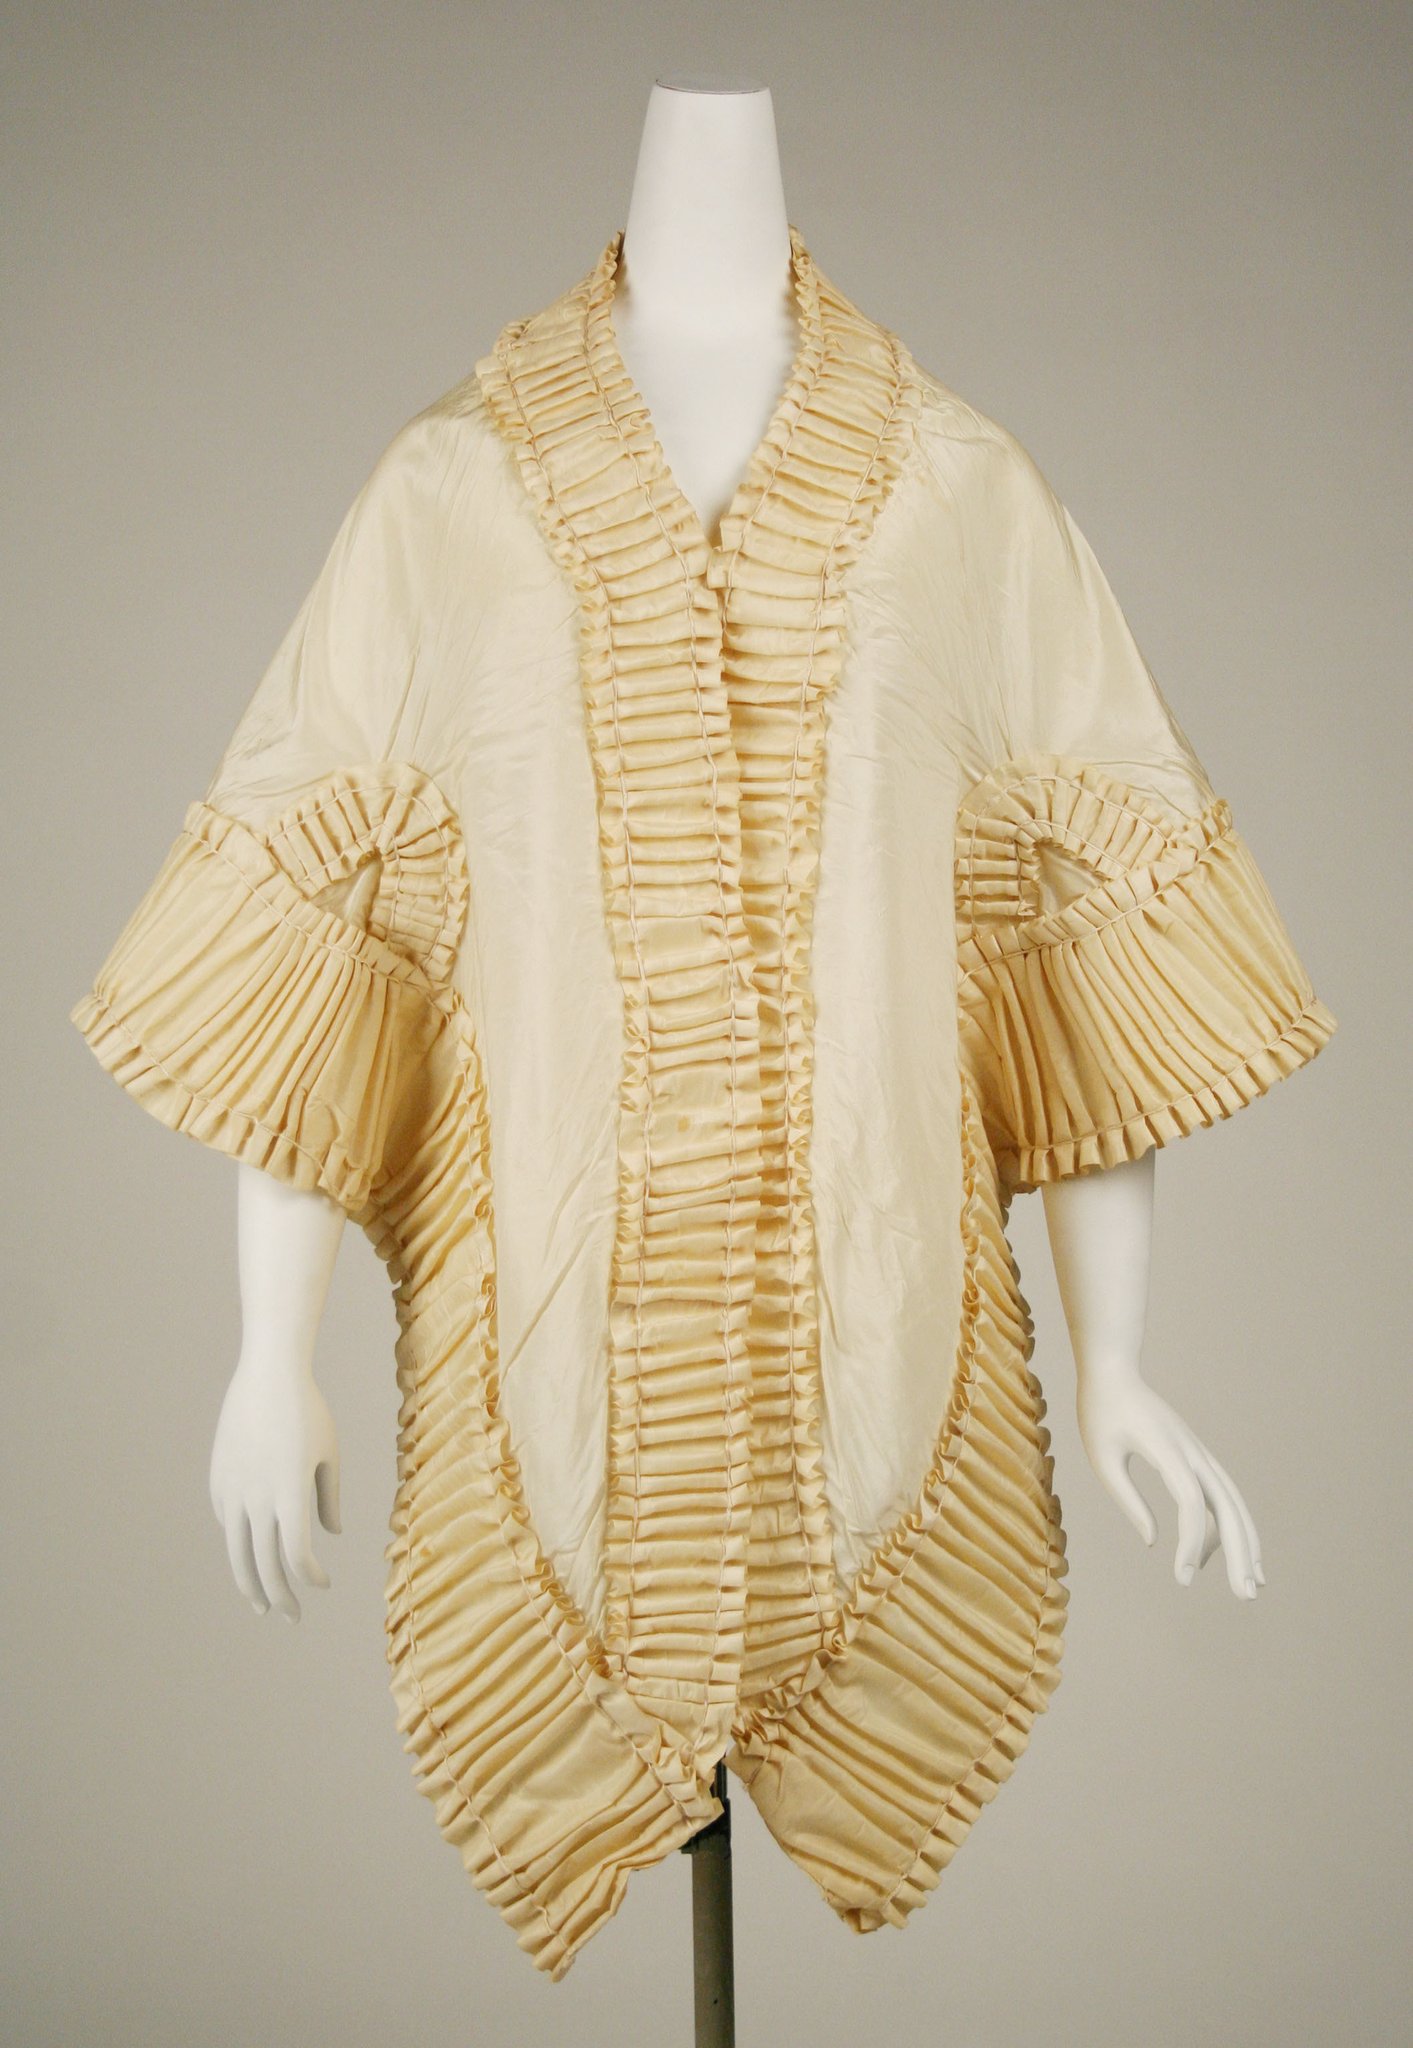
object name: pelerine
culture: american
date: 1872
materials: silk